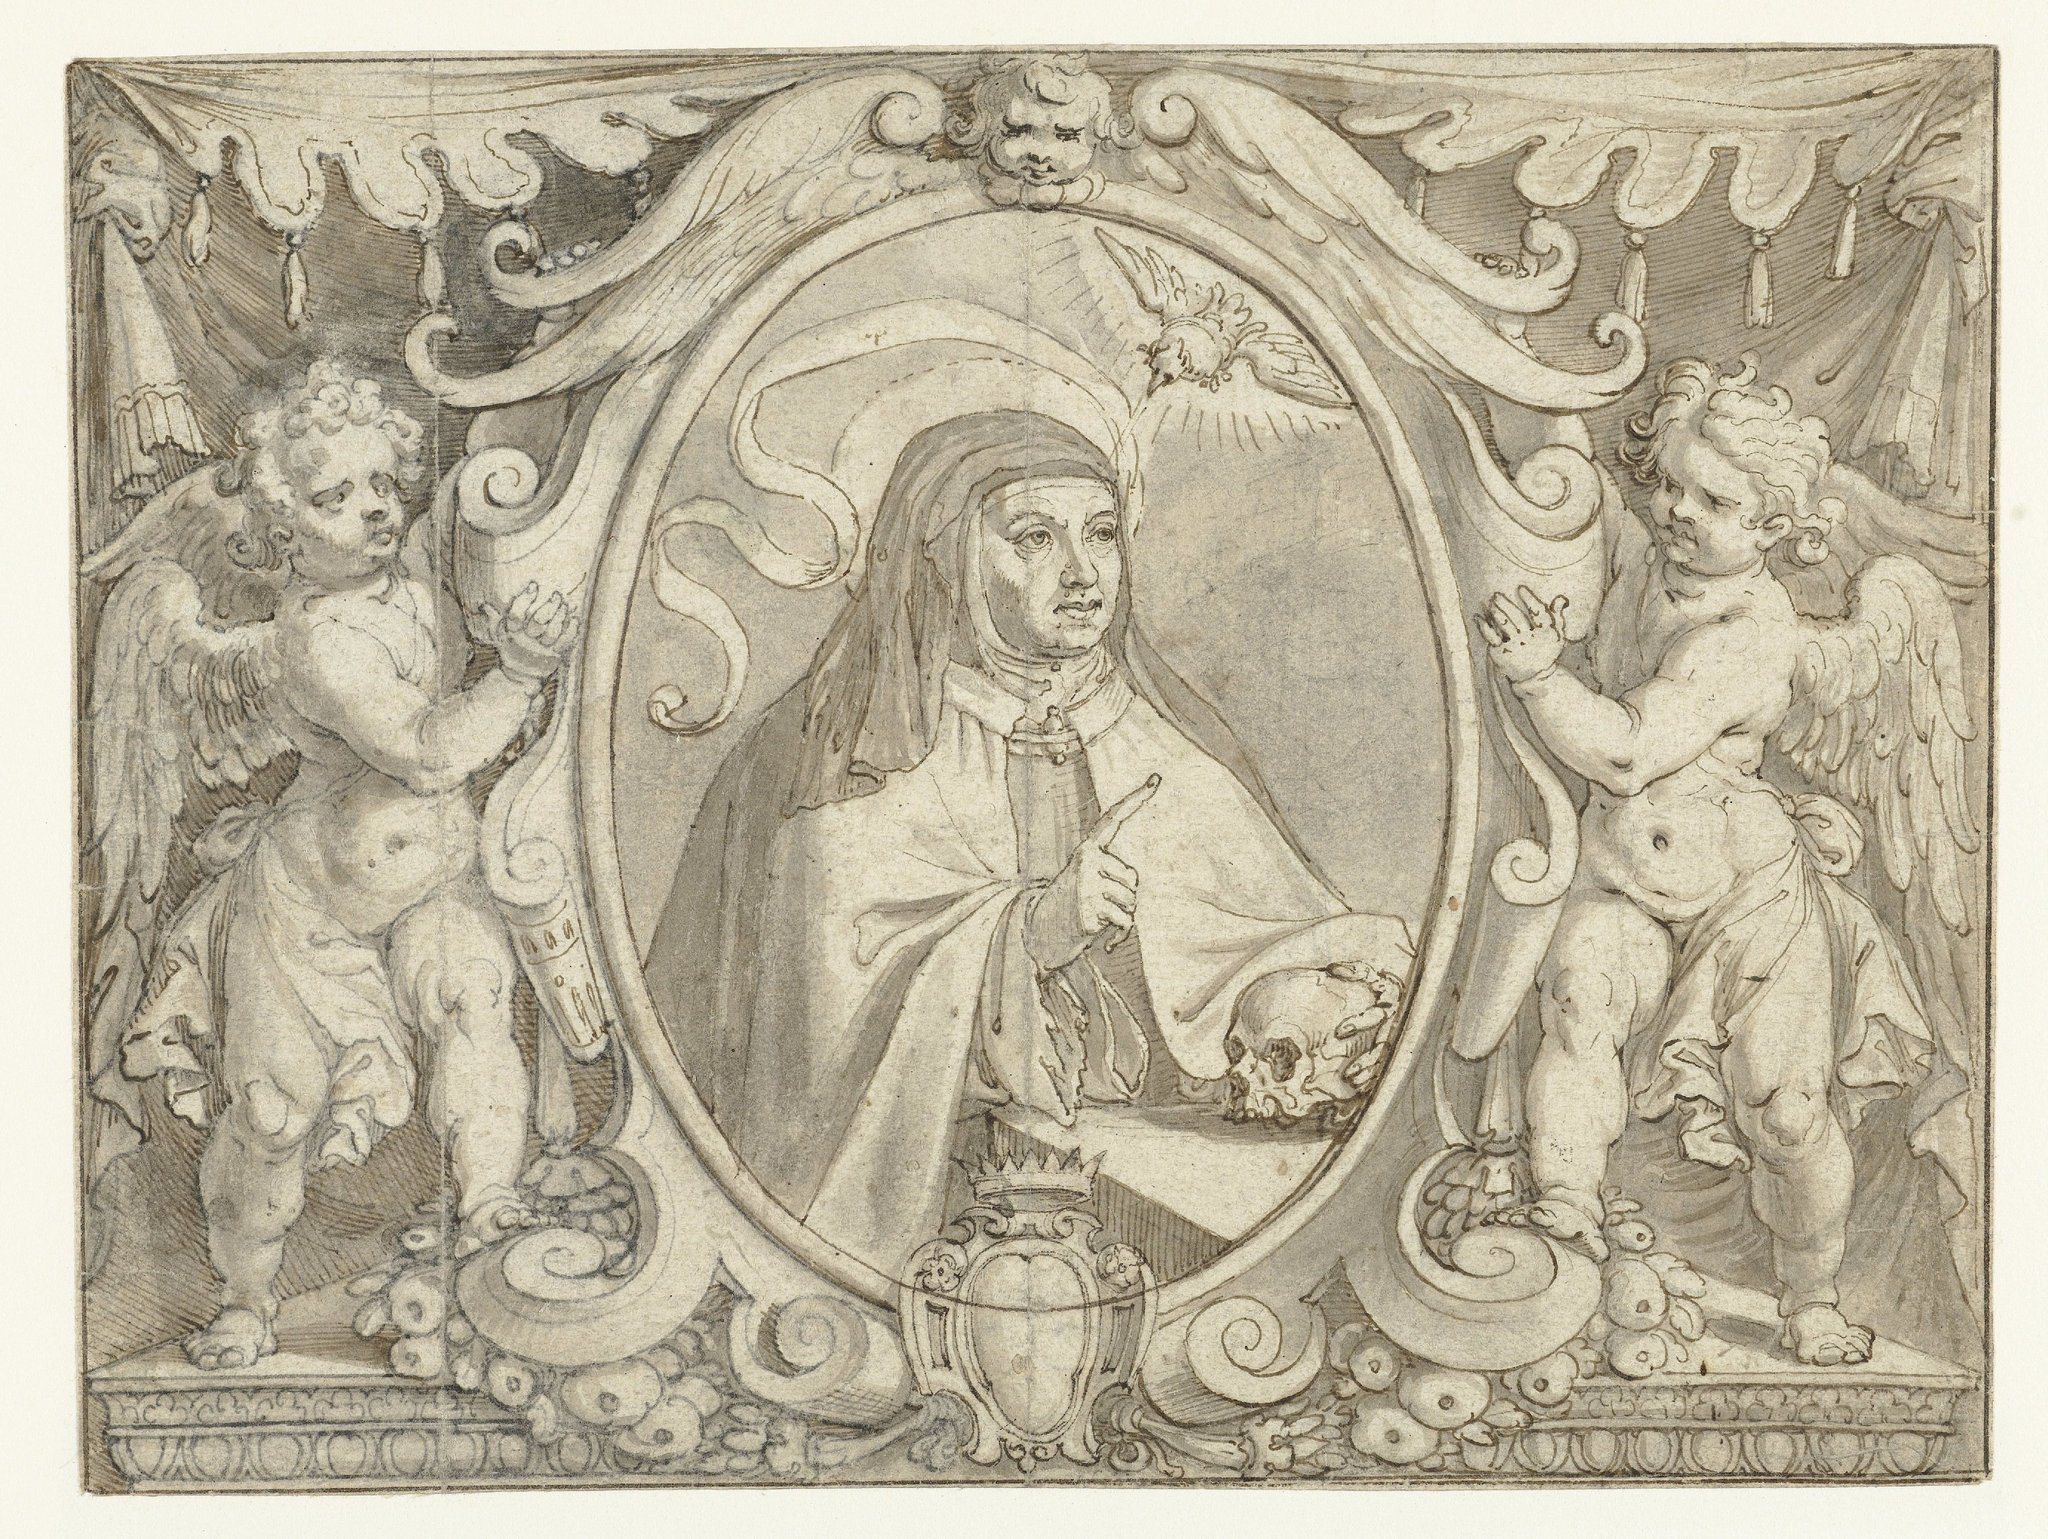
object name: design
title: Portret van Teresa van Avila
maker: pieter de jode (i)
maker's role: draughtsman, print maker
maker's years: 1570-1634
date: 1611-1613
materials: ink, paper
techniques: brush, pen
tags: the foundress of the reformed (discalced) carmelites, t(h)eres(i)a of avila; possible attributes: angel, arrow, dove, heart (flaming or pierced by an arrow), historical persons